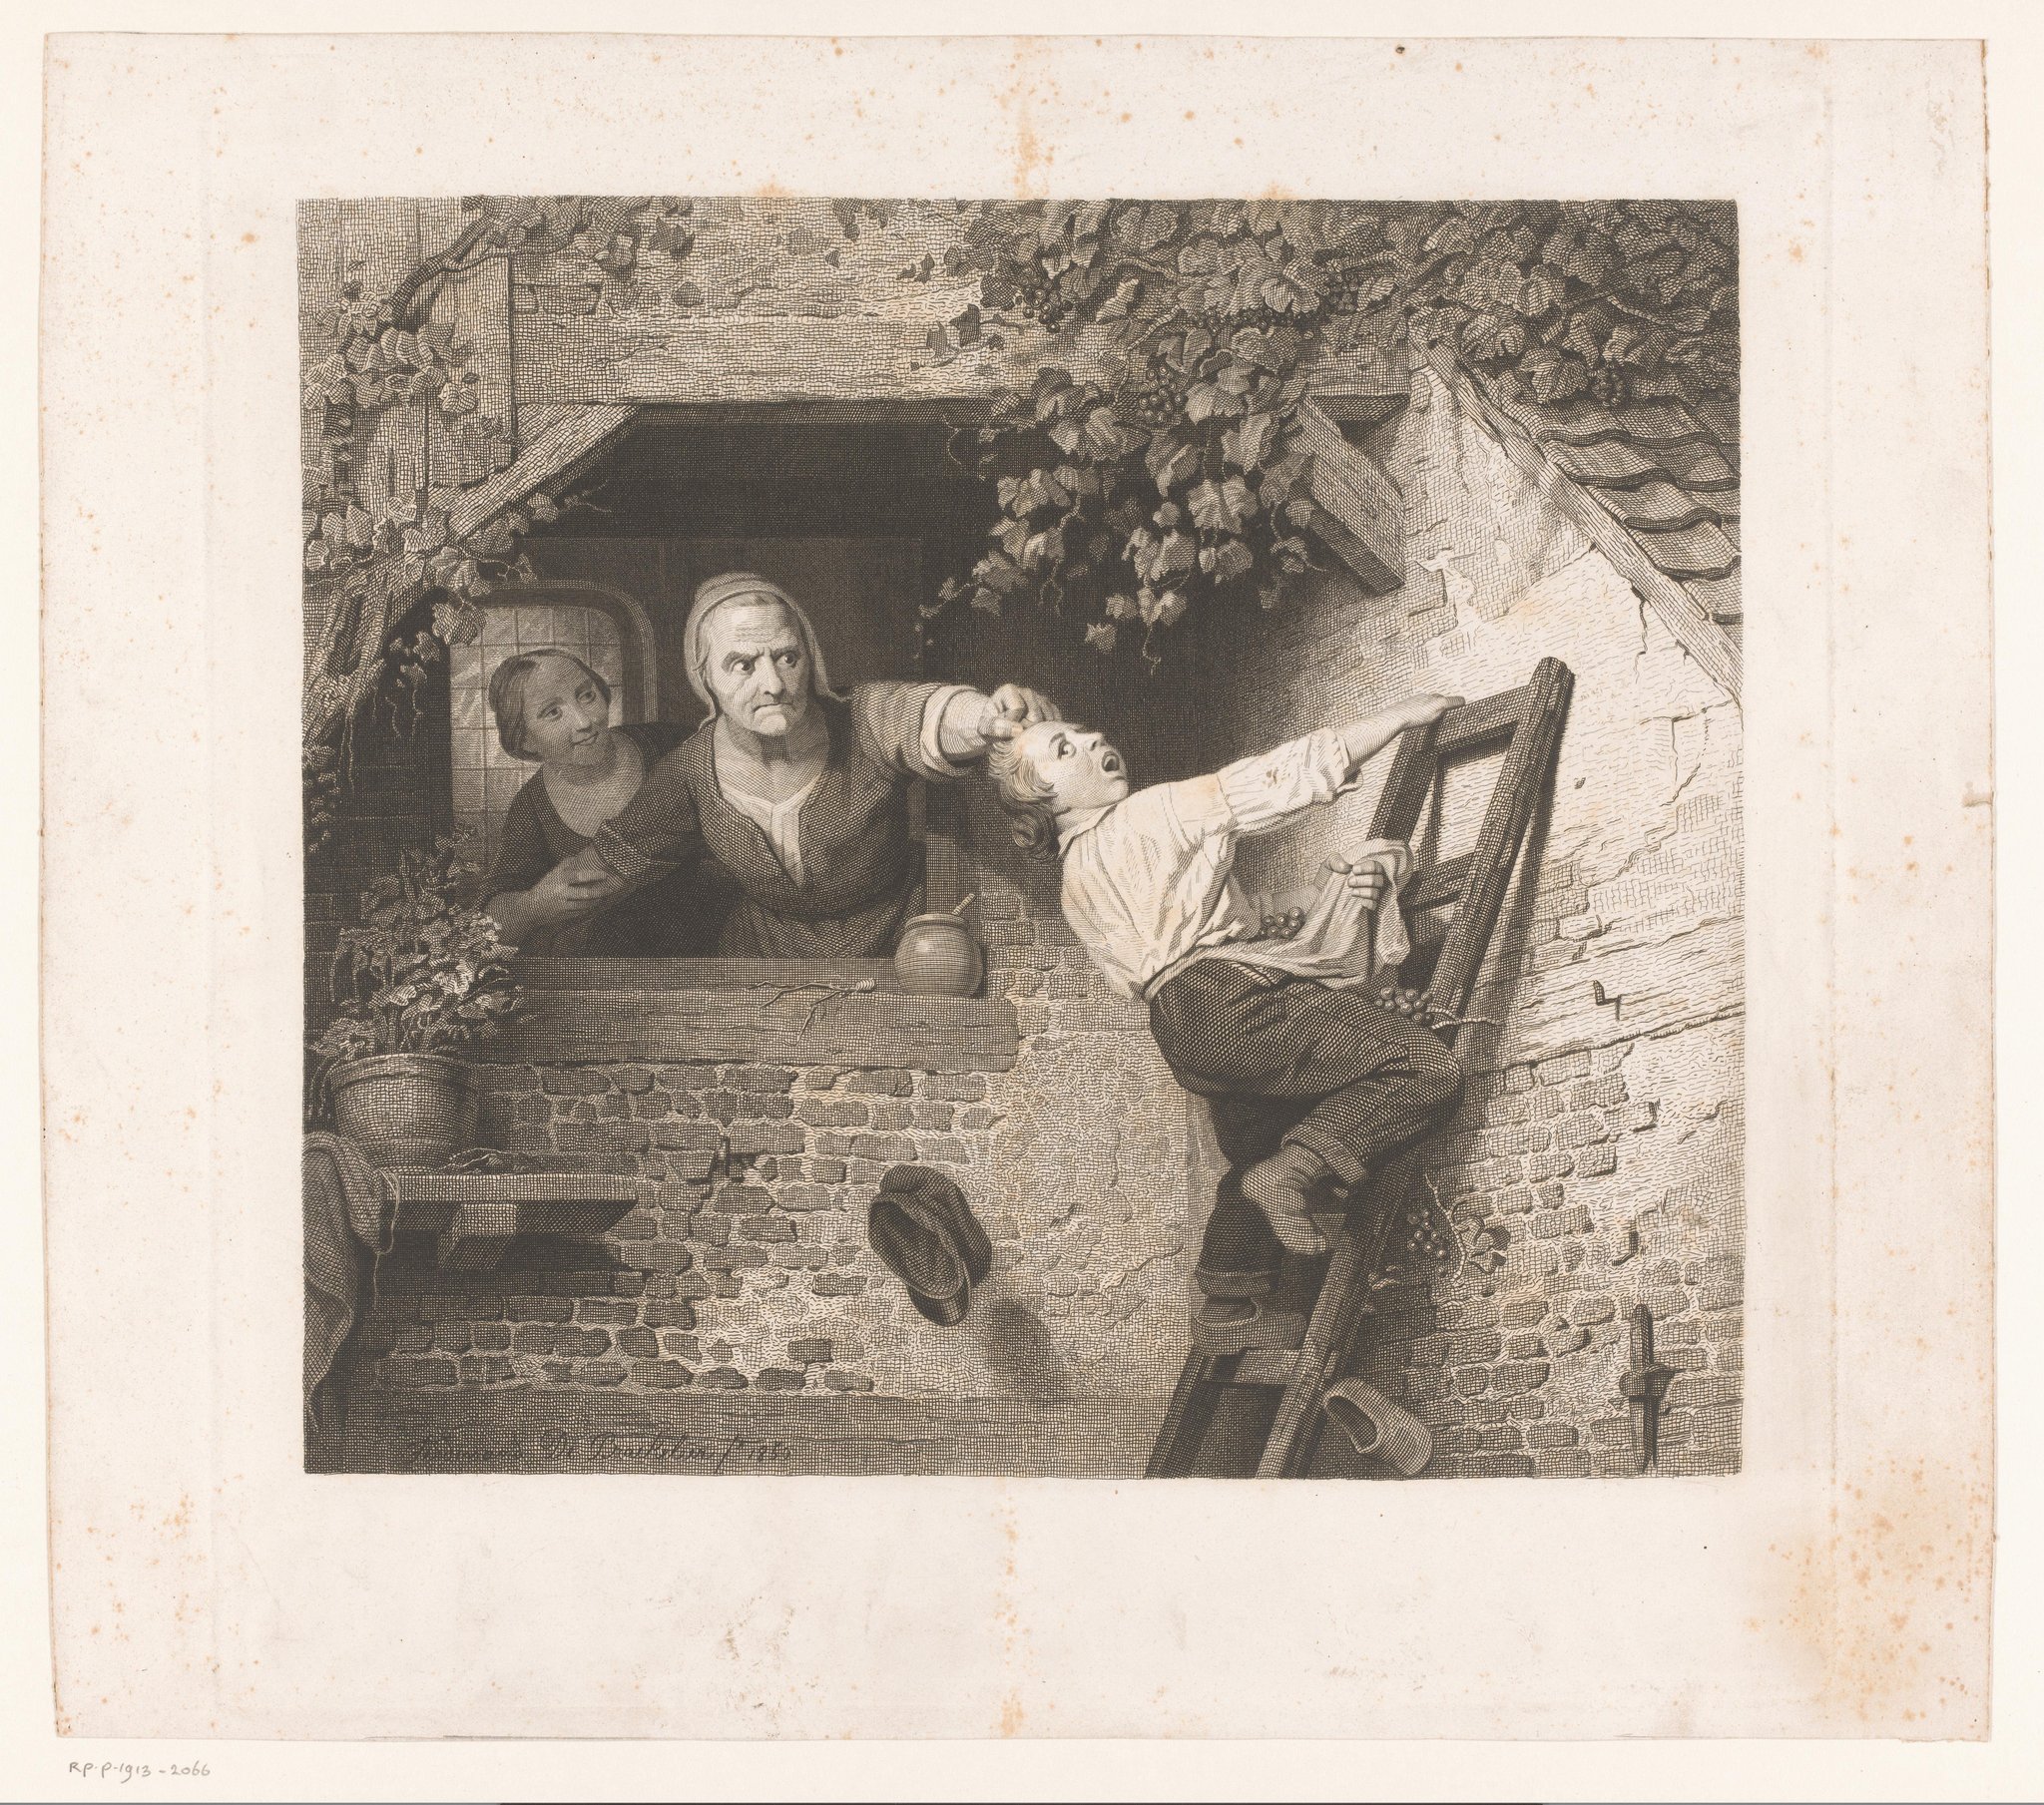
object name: print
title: Jongen op een ladder wordt betrapt op het stelen van druiven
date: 1850-1886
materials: paper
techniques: engraving, etching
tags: vine, thief, ladder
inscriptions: collector's mark: Lugt 2228